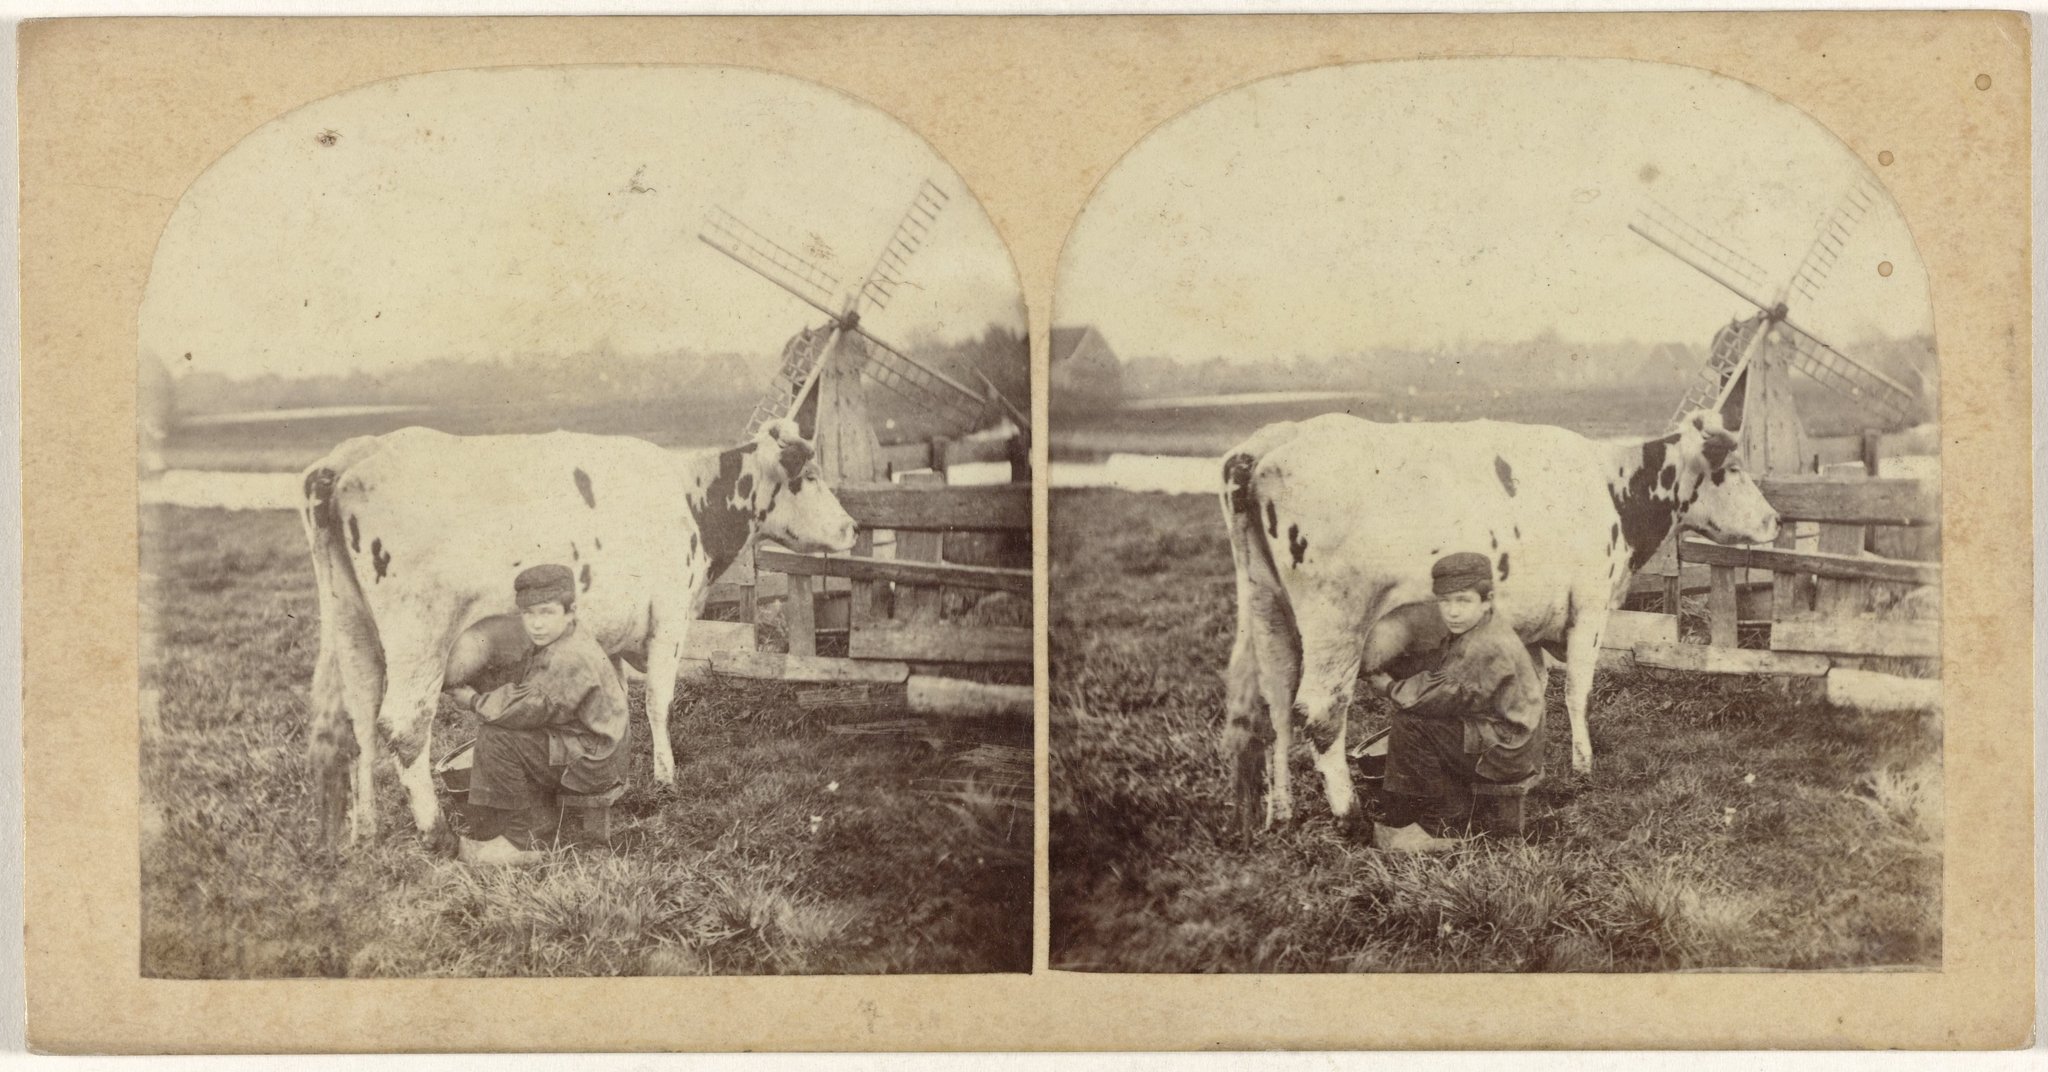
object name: stereograph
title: Jongen melkt een koe in Krommenie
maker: klaas van vliet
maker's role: draughtsman, painter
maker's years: 1841-1917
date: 1856-1880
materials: cardboard, paper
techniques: albumen print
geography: krommenie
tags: boy (child between toddler and youth), windmill in landscape, milking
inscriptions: number: ‘13.’, inscription: ‘70 C.’